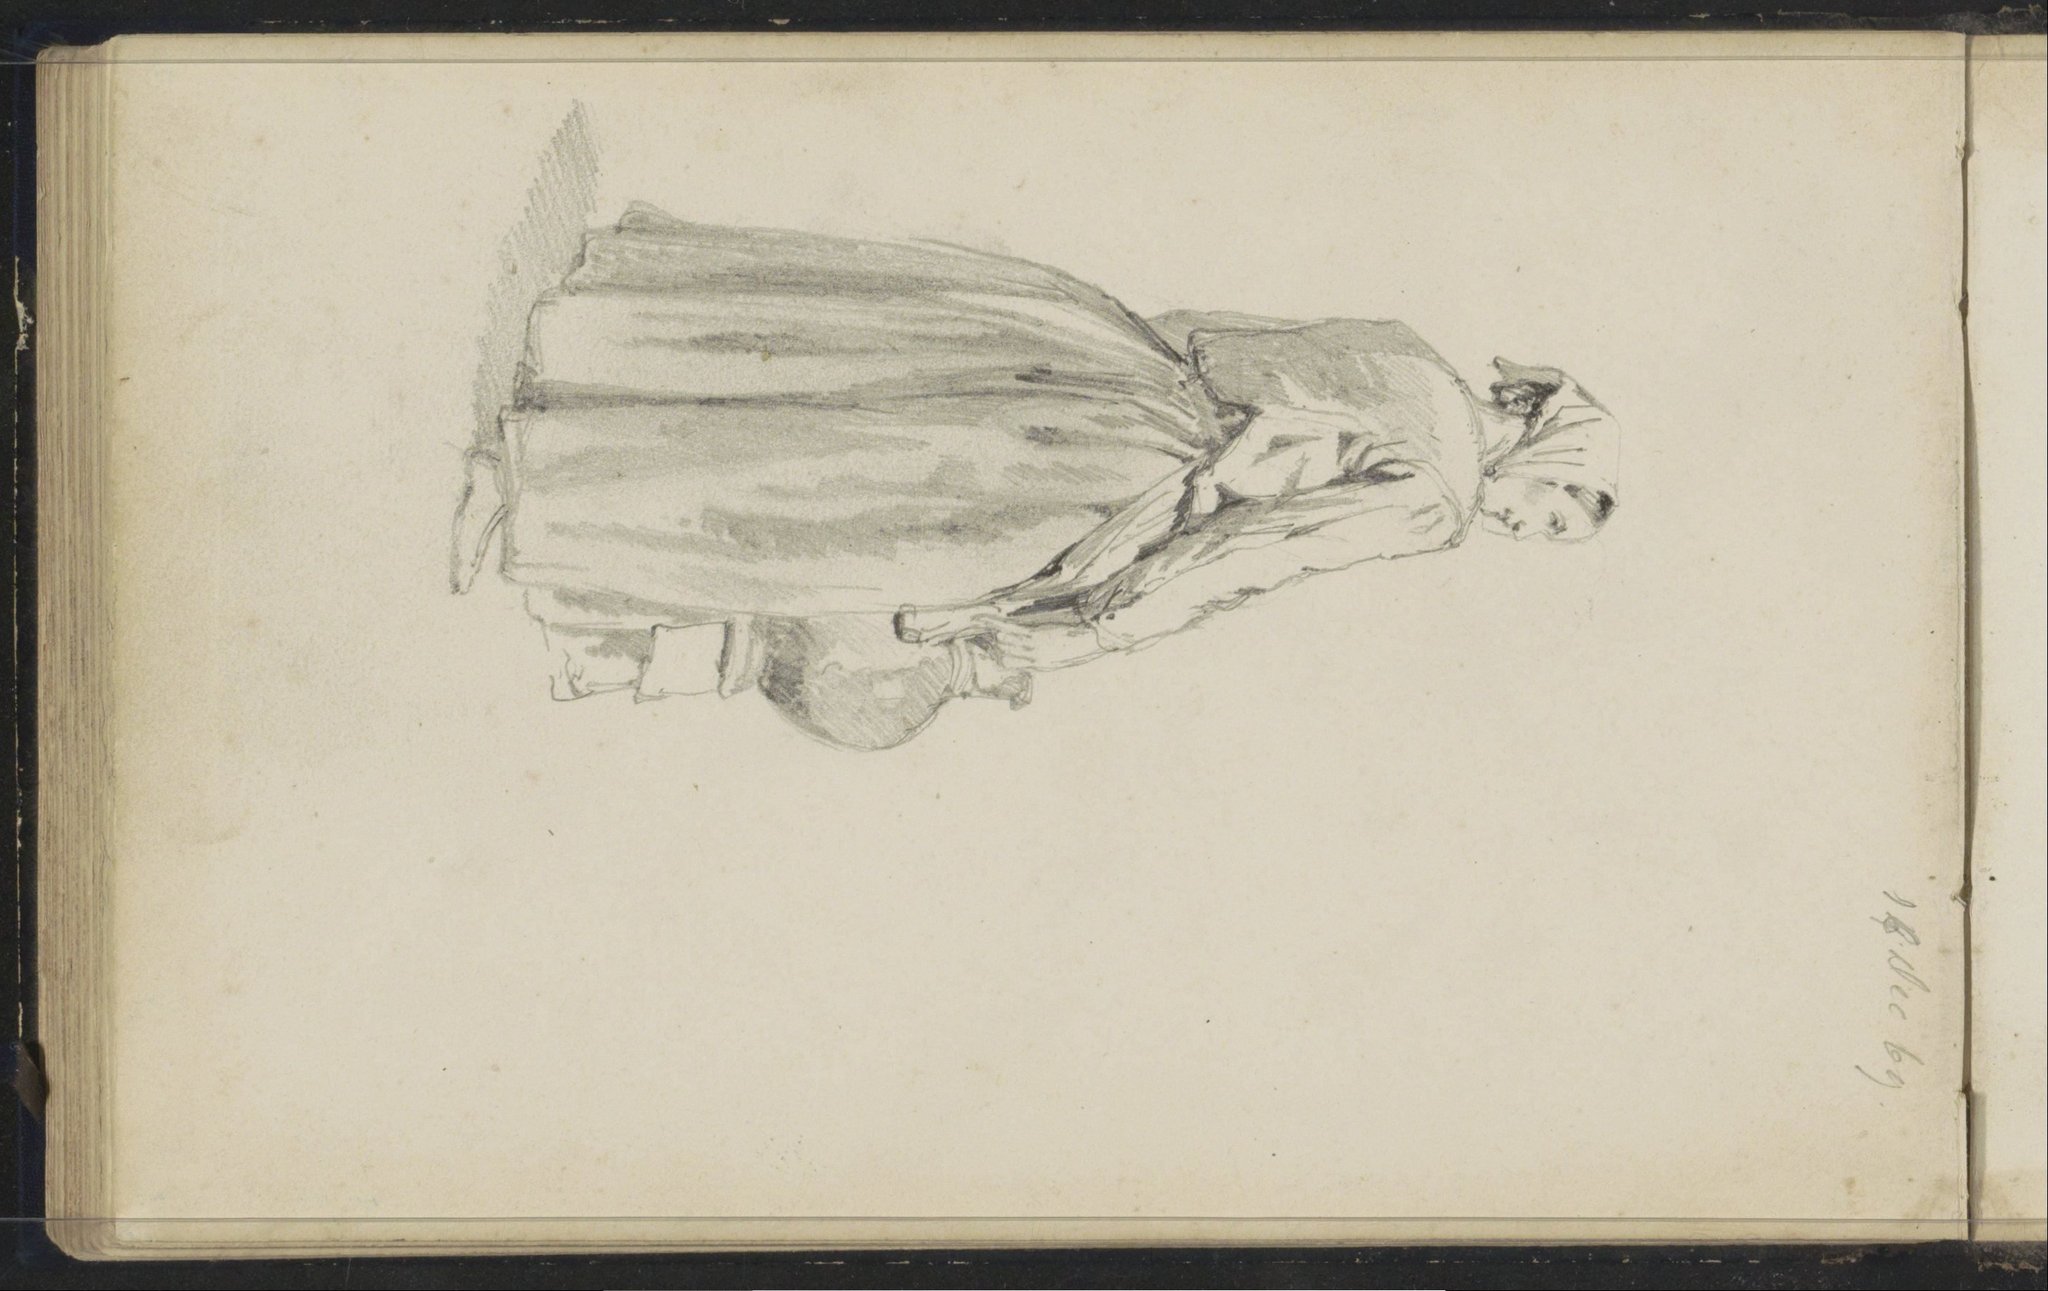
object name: sketchbook leaf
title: Vrouw met een kruik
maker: cornelis springer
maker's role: draughtsman, painter, print maker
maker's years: 1817-1891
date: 1869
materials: paper, pencil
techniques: stumping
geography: netherlands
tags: adult woman, container of ceramics: jar, jug, pot, vase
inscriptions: date: ‘16 Dec 69’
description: Vrouw met een kruik. Blad 40 verso uit een schetsboek met 40 bladen, vervaardigd in Woerden en Gouda.